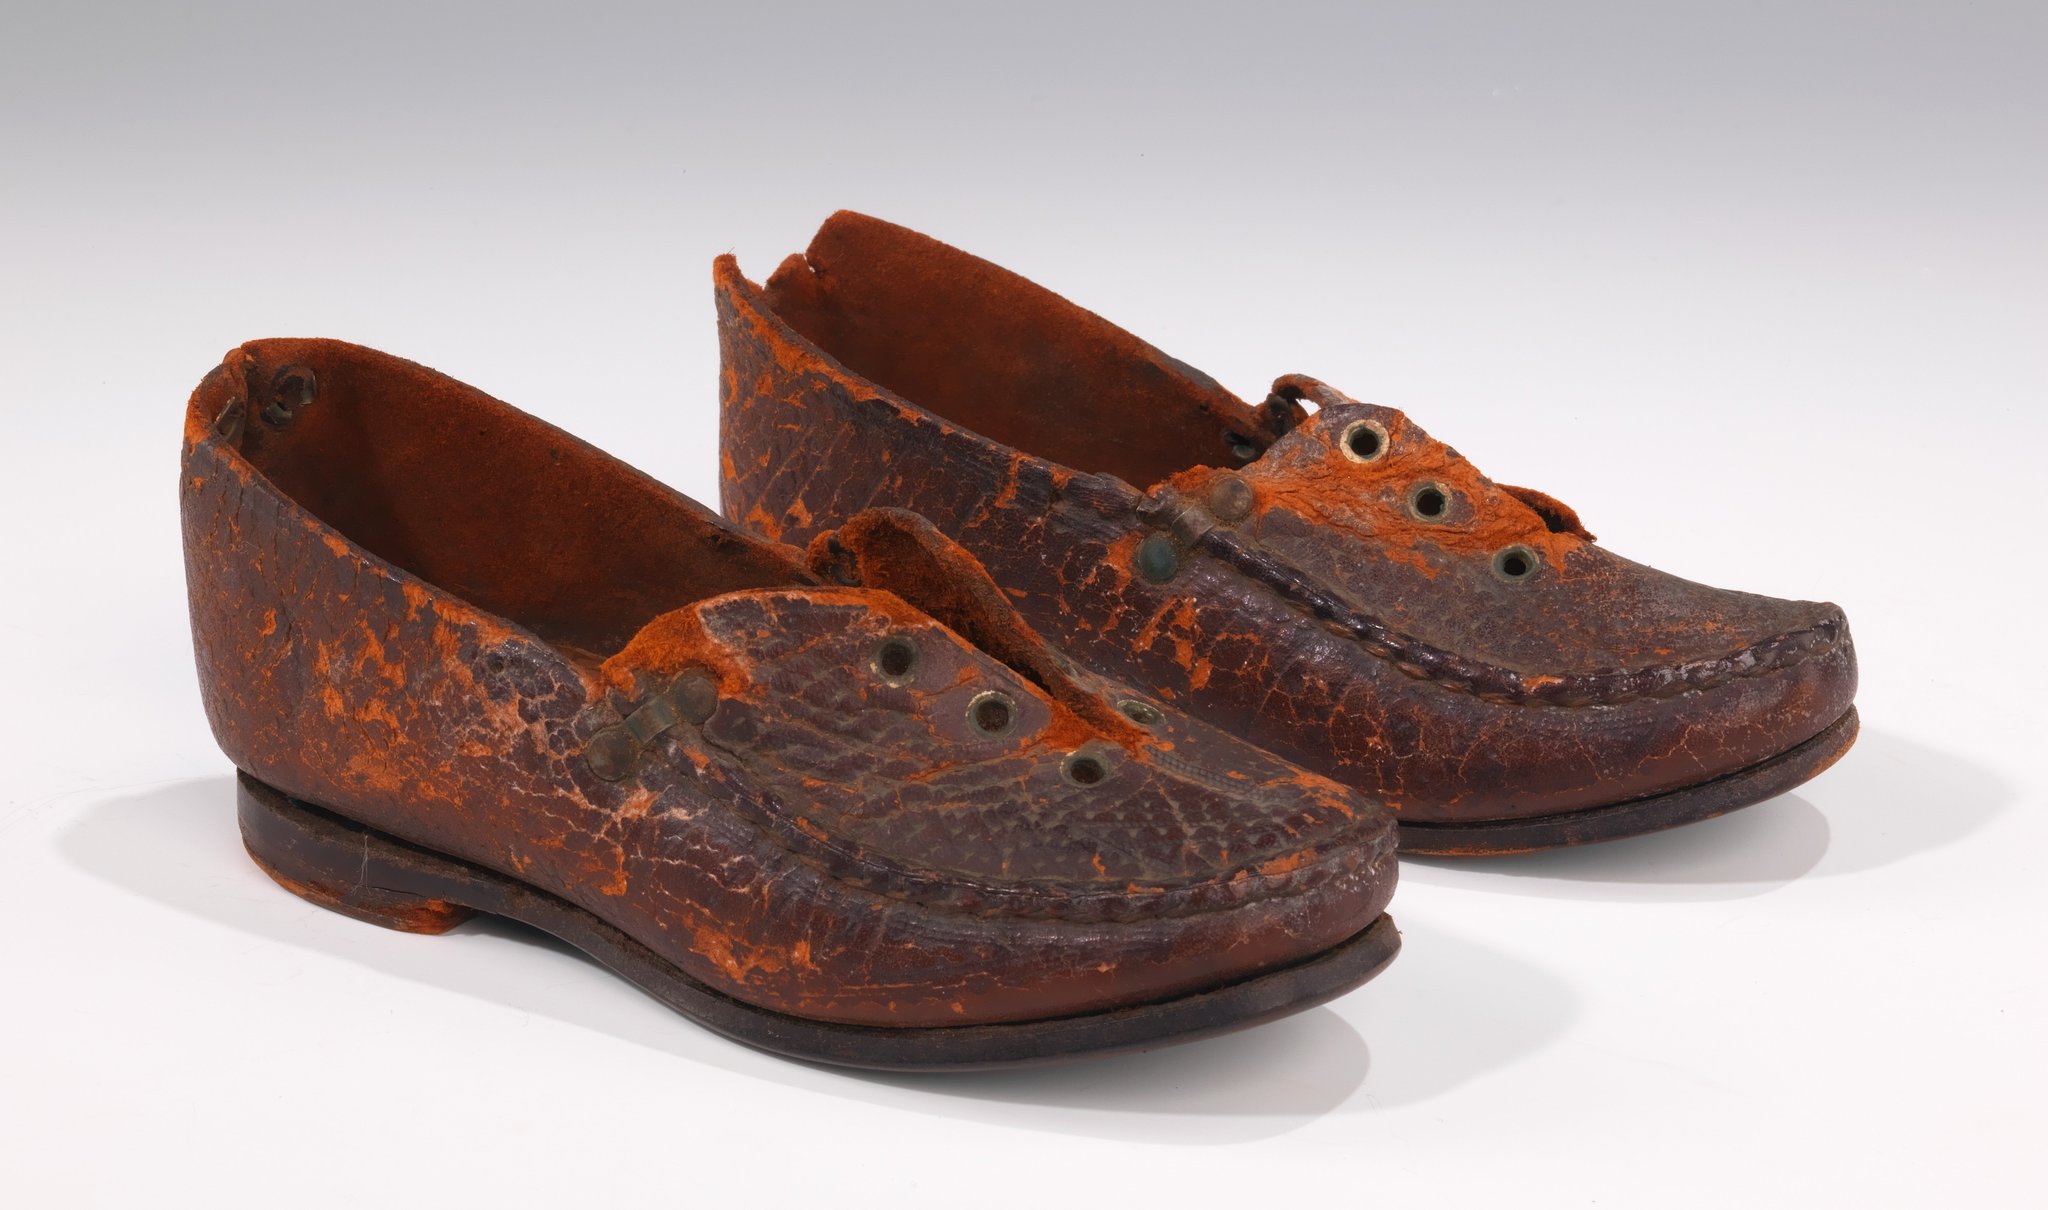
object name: shoe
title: Shoes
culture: european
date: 1860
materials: leather